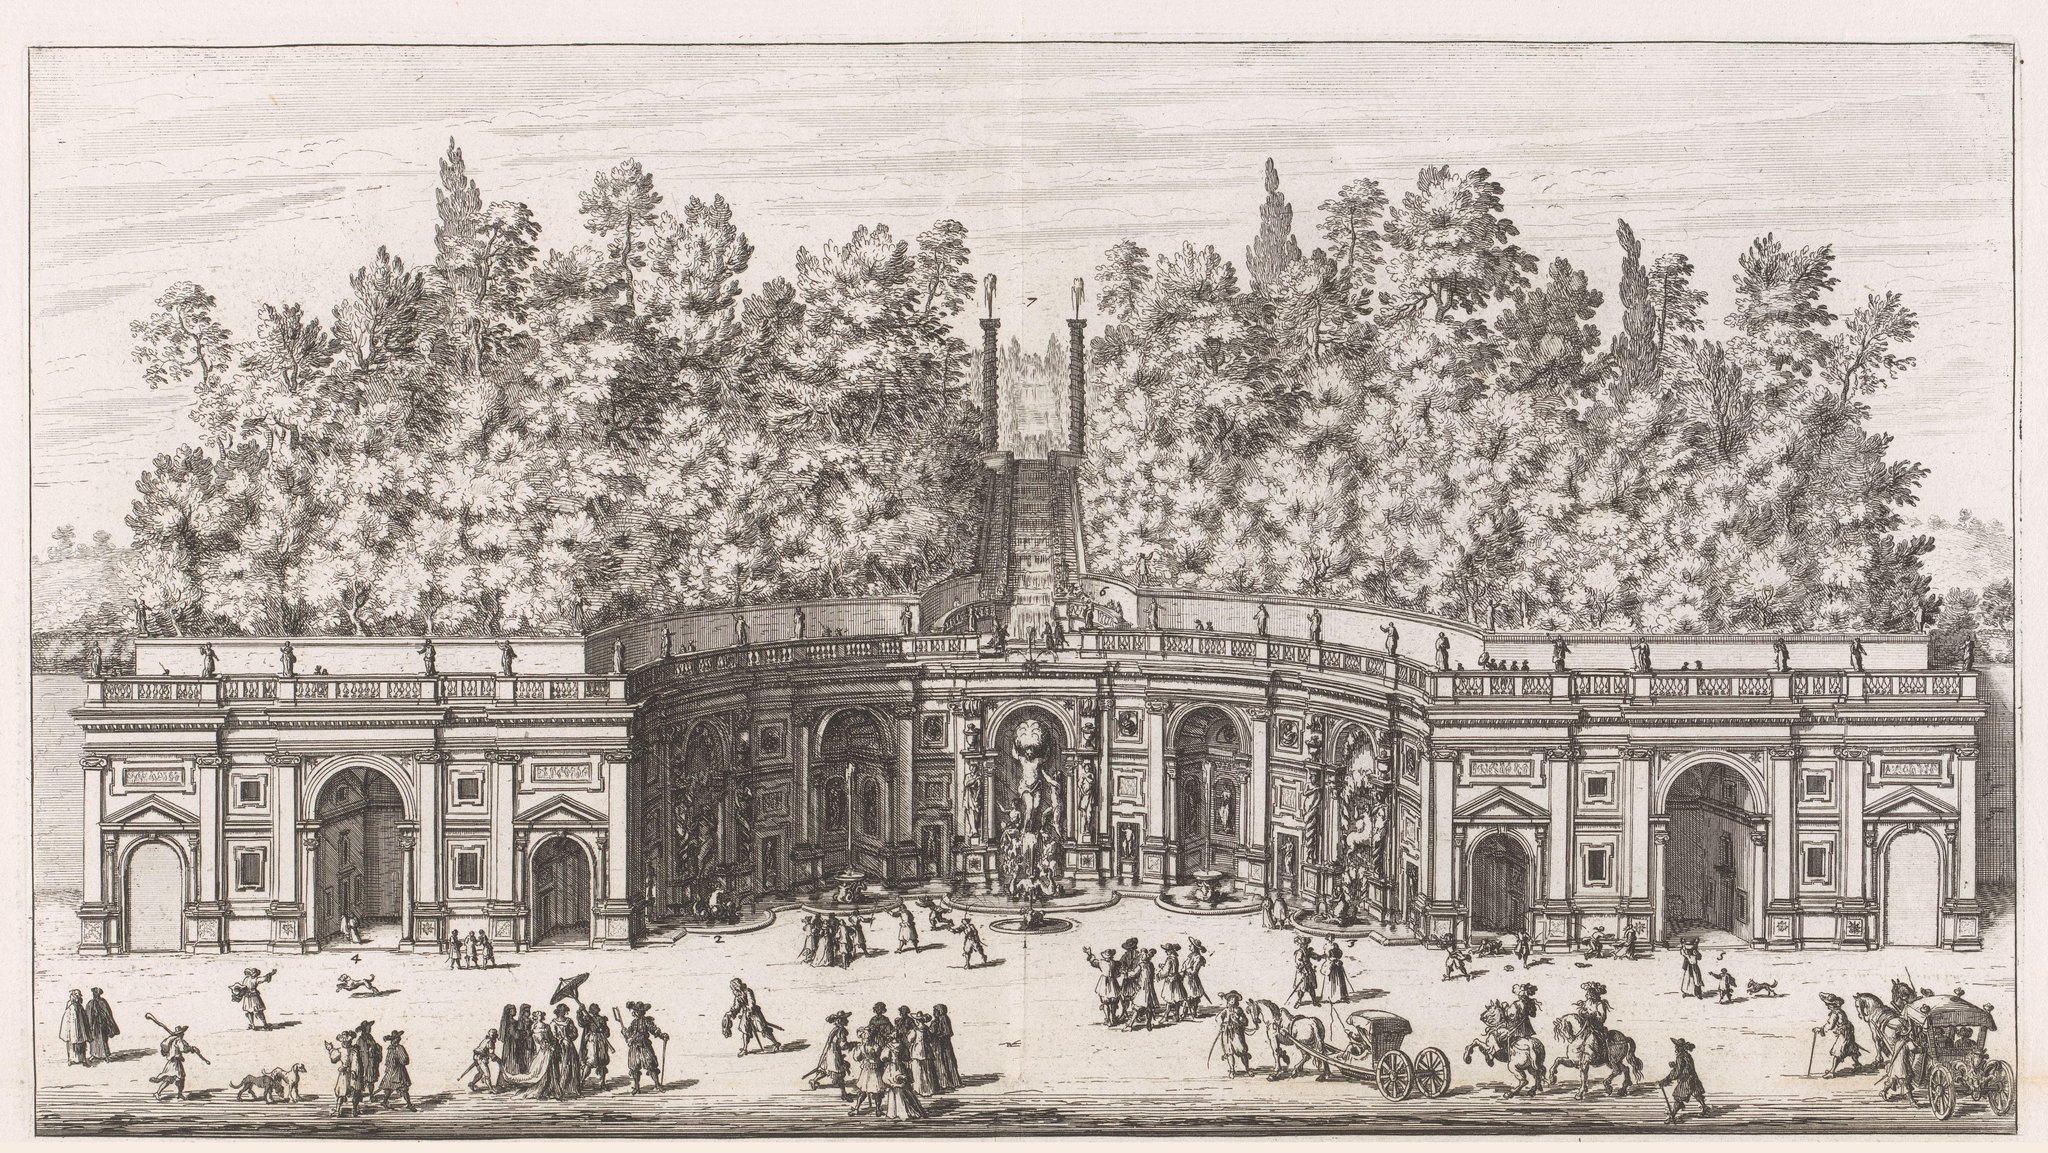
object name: album leaf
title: Veduta e prospetto del gran Teatro dell'Acque della Villa Aldobrandina (...)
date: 1653-1691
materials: paper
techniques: etching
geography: vatican city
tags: ornamental fountain